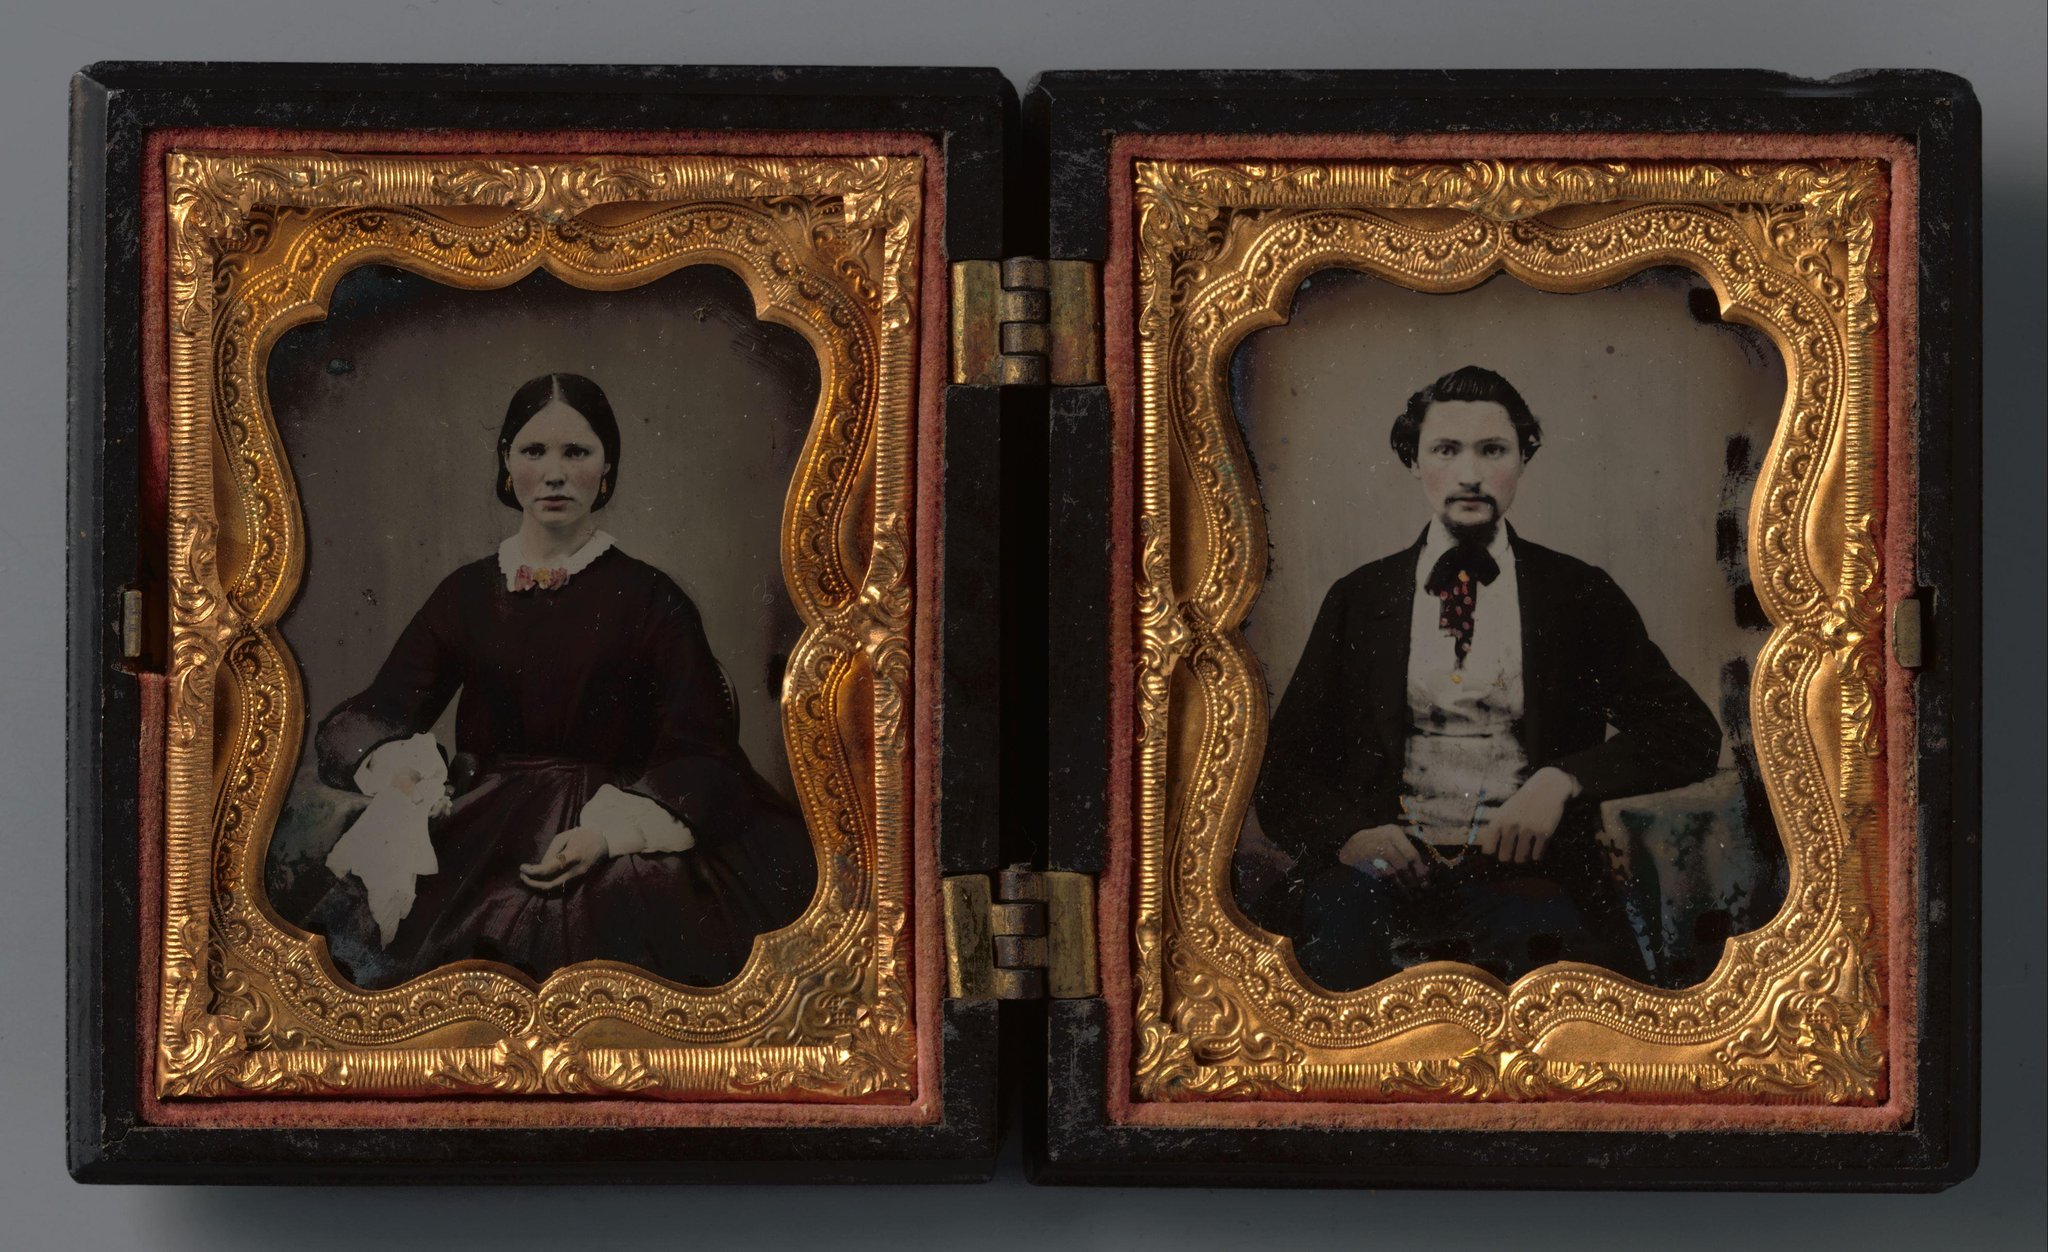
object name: photograph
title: Portret van een onbekende jongeman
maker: Anonymous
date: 1855-1870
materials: glass, metal, plastic, velvet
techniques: ambrotype, hand coloring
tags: sitting figure, historical persons